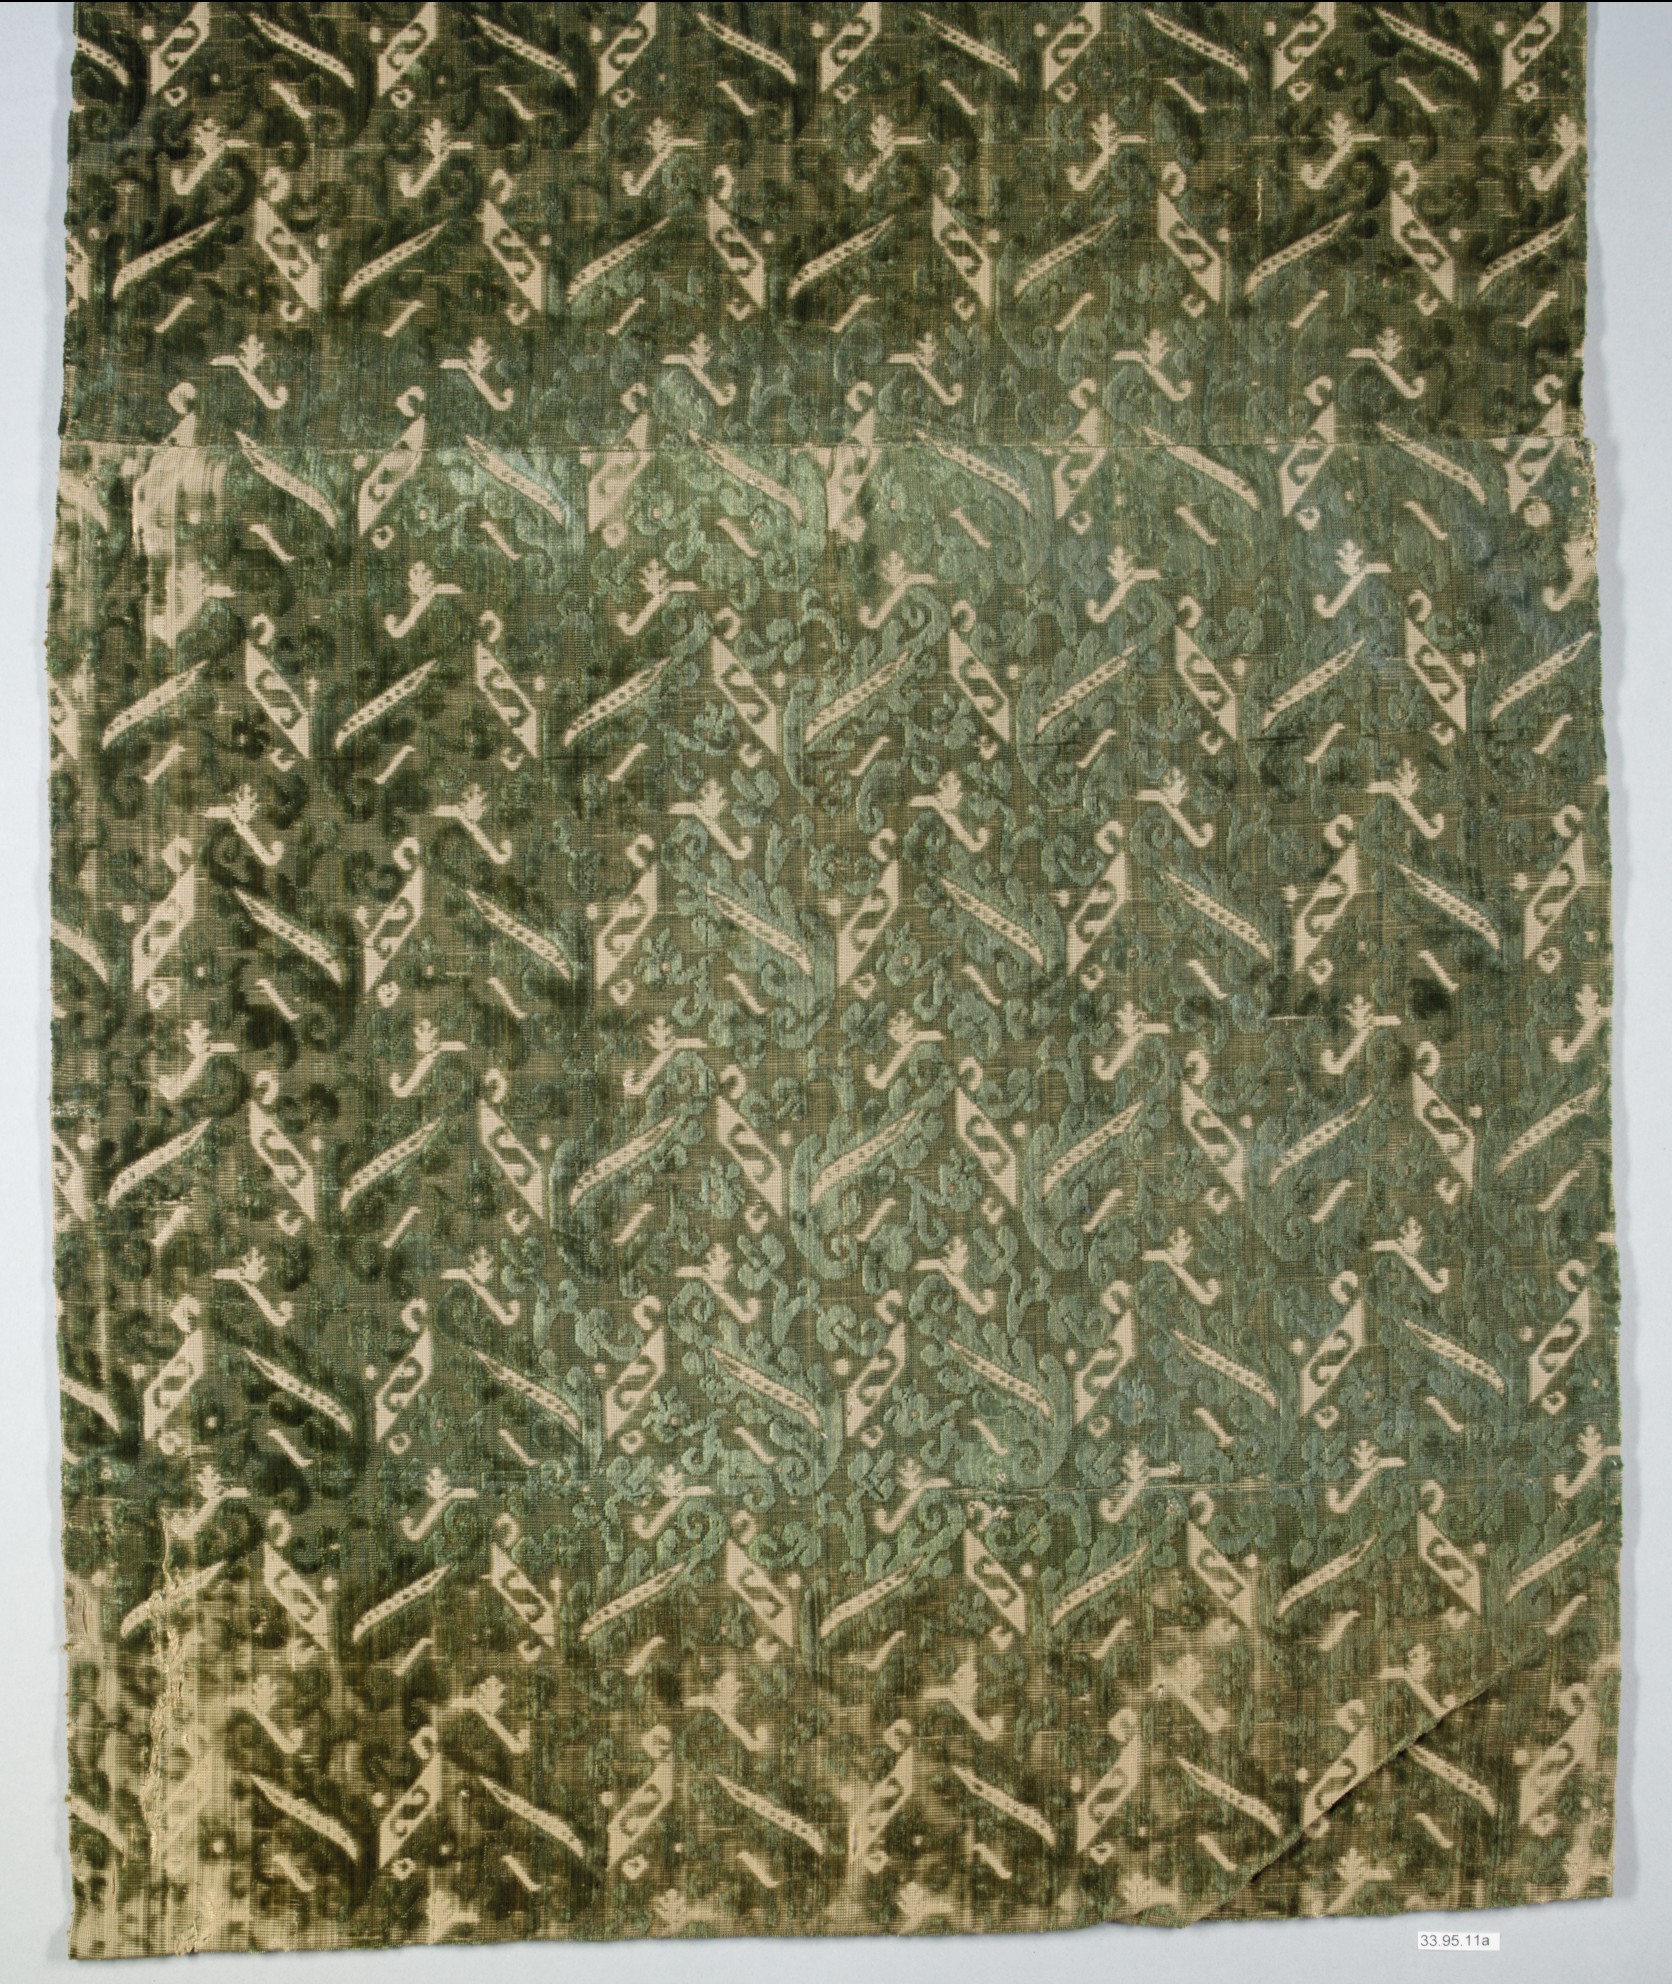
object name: piece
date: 1501-1700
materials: silk